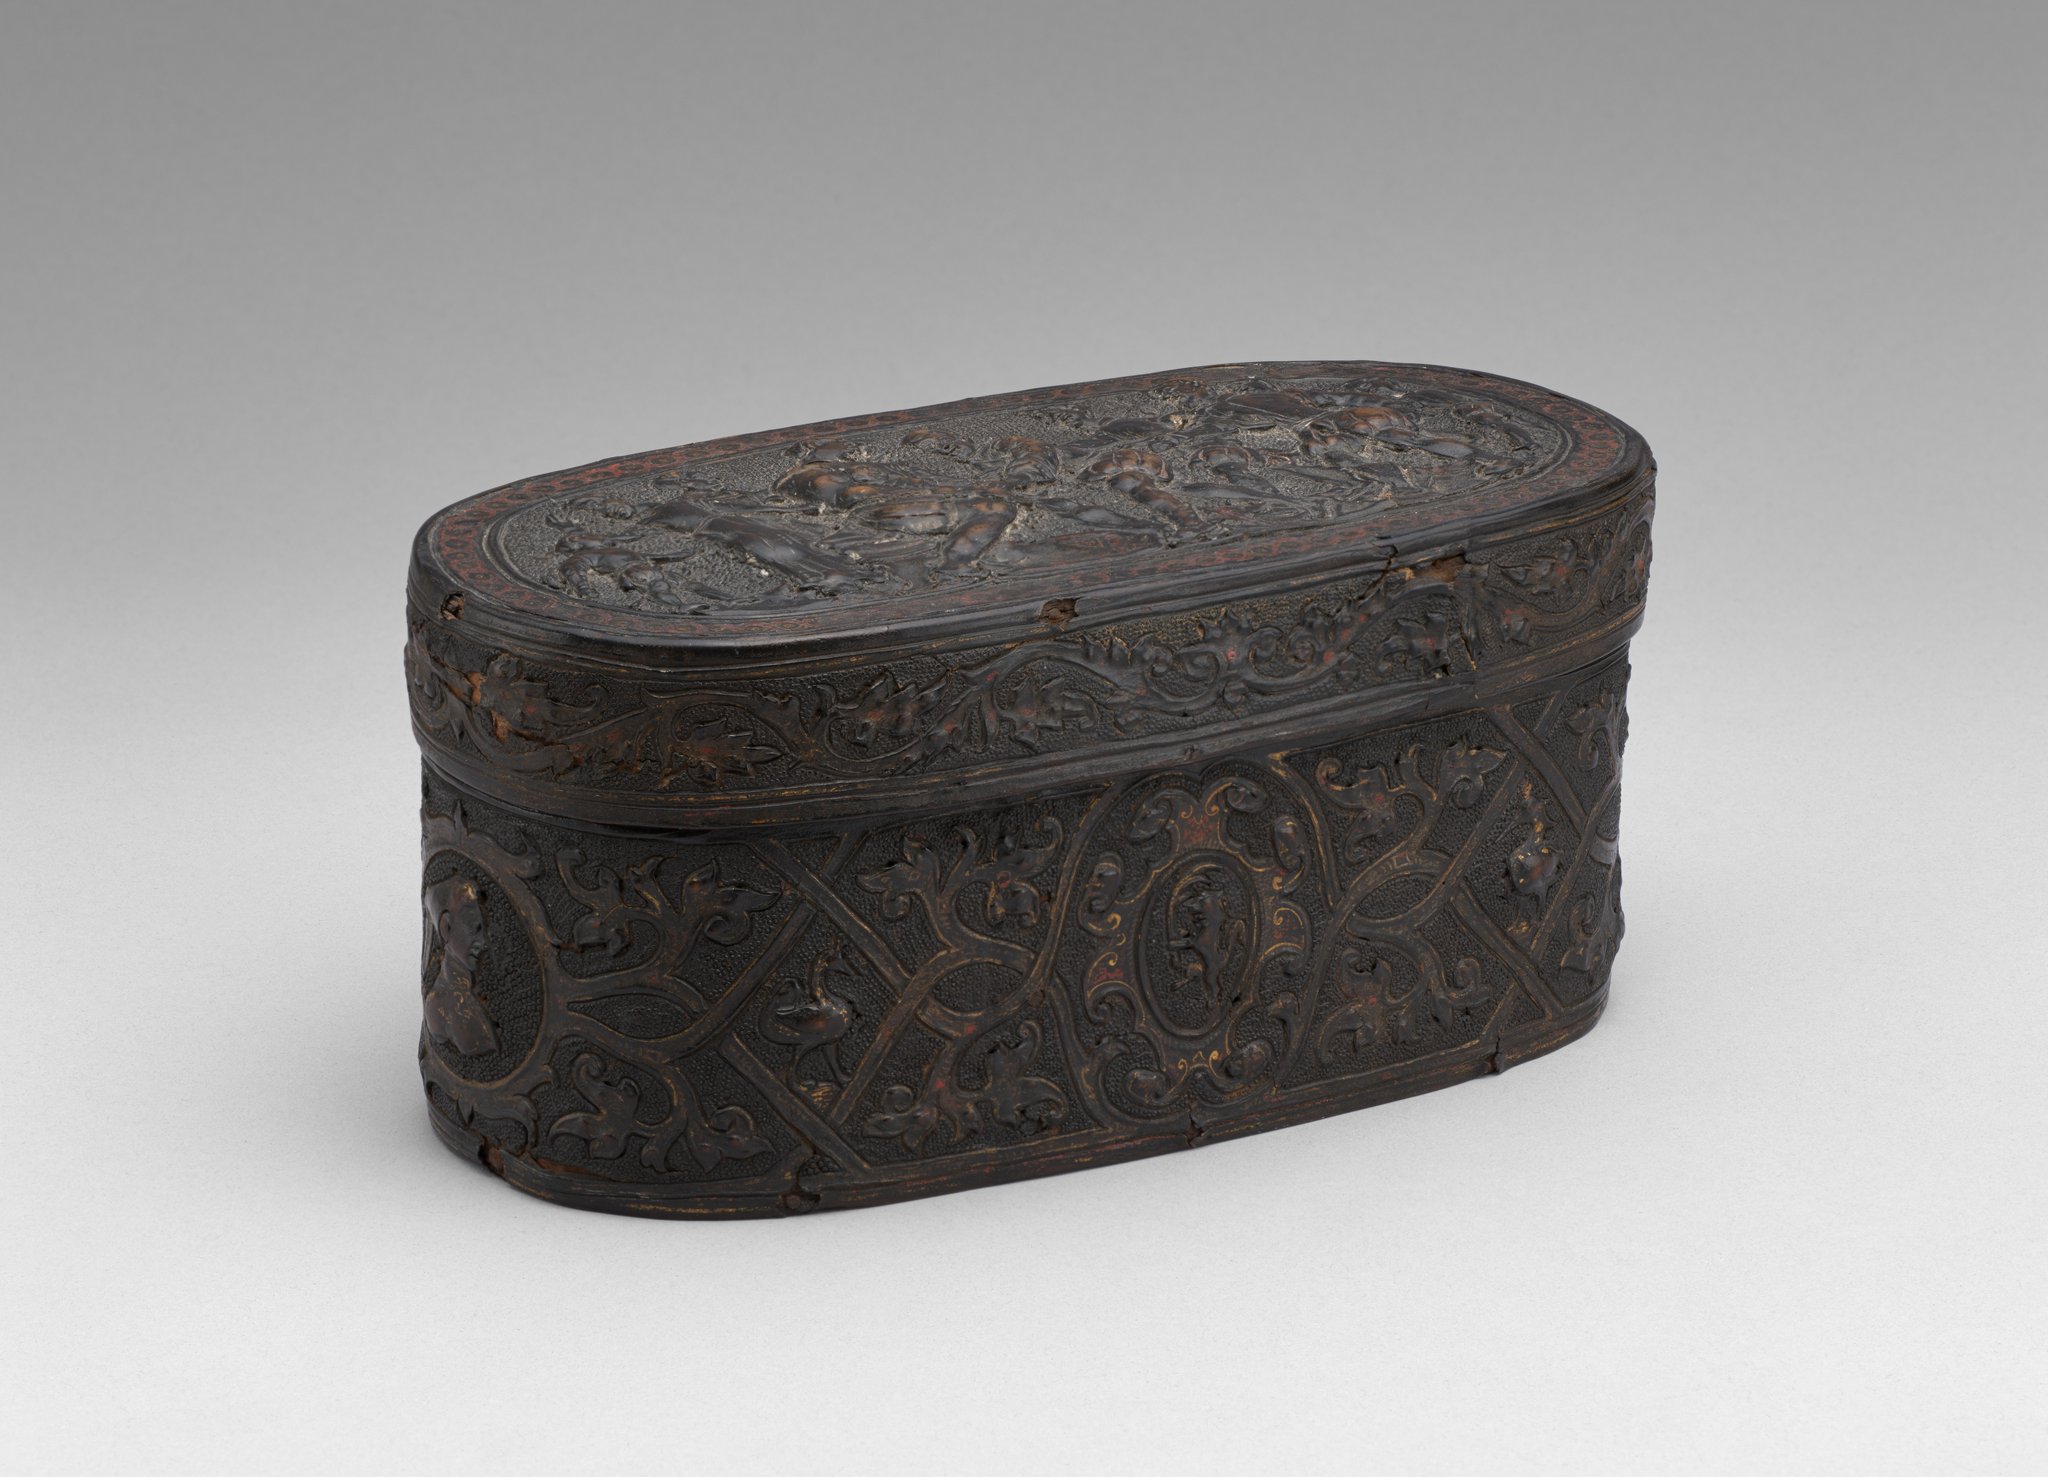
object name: box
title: Box for circumcision instruments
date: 1520-1530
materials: leather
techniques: gilding, molding, painting, polychromy, tooling